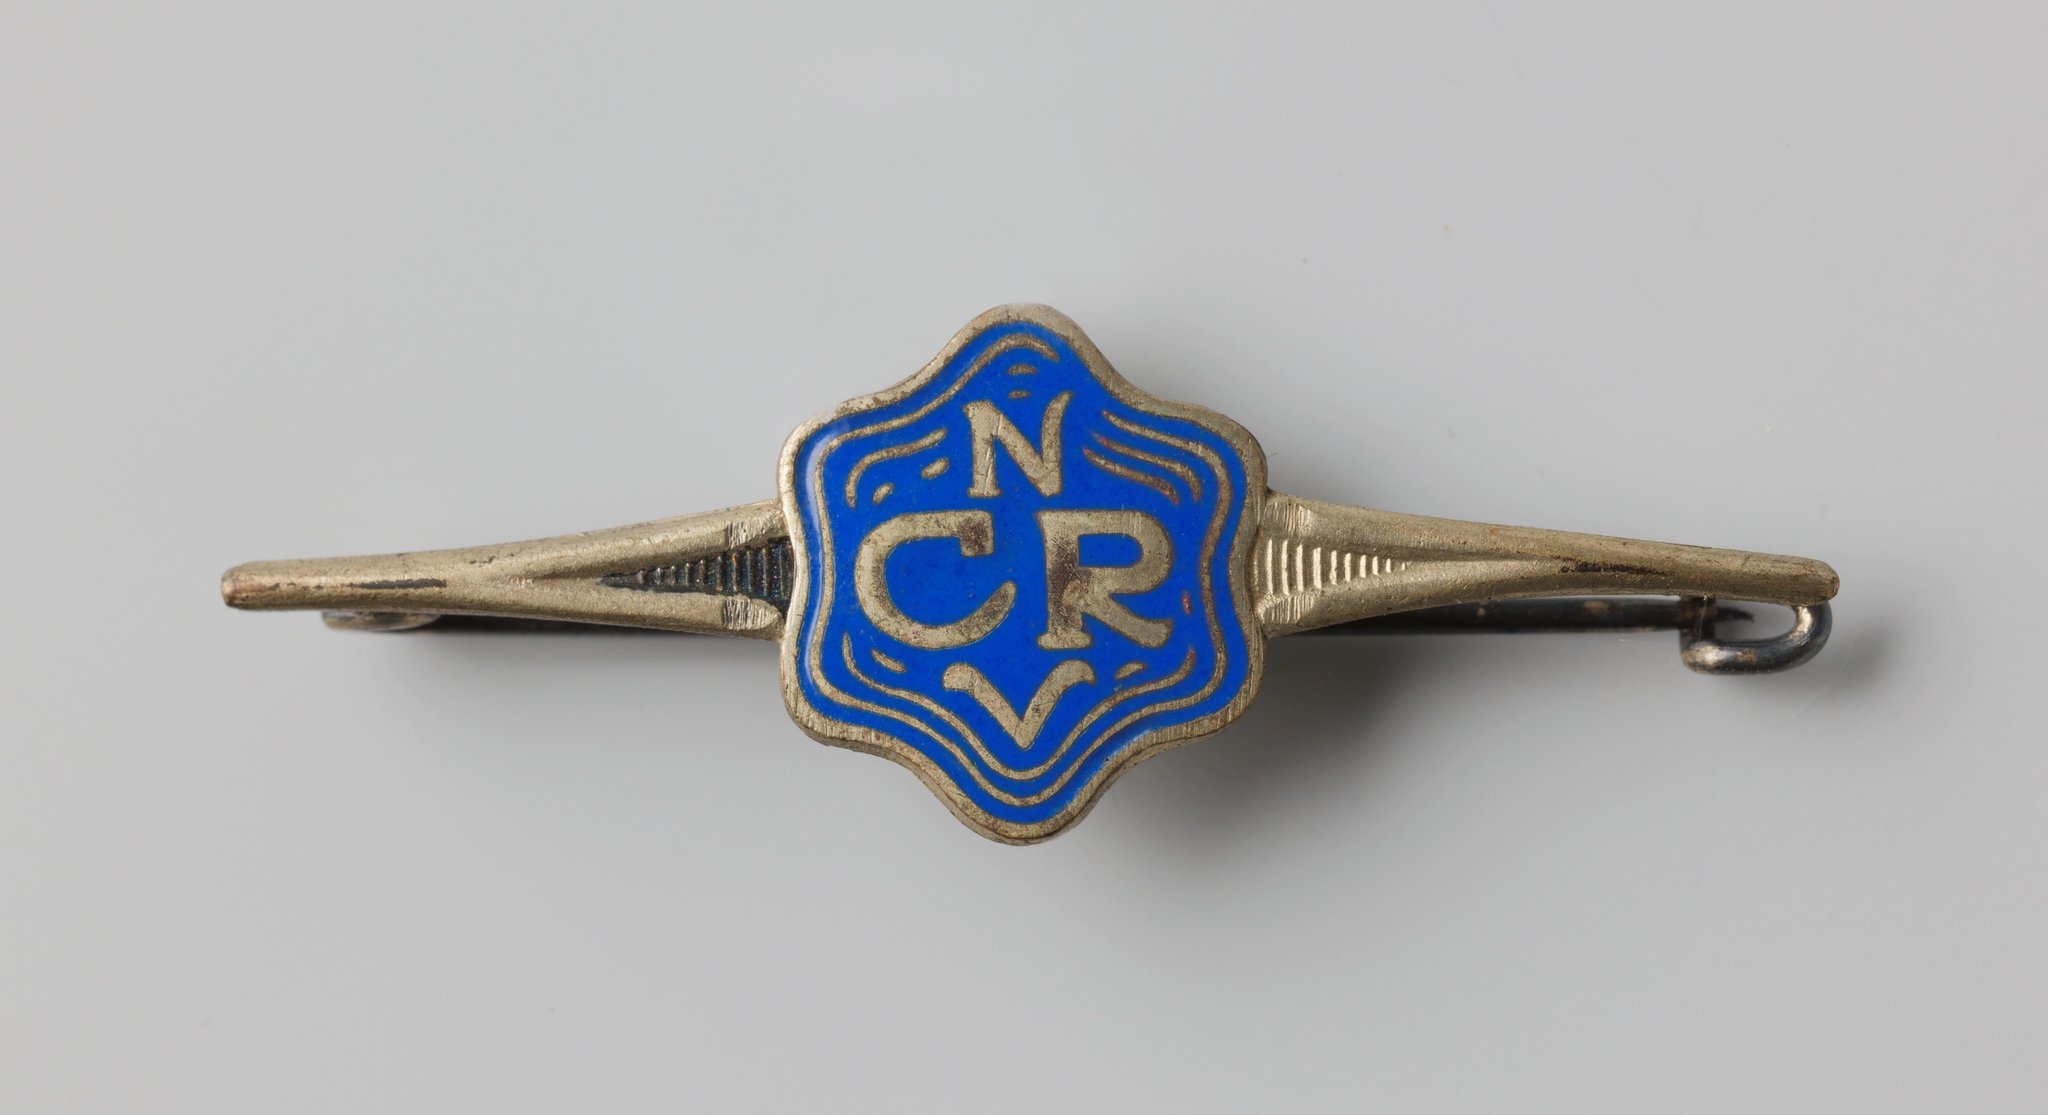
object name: pin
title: Reversspeld van de Nederlandse Christelijke Radio Vereniging (NCRV)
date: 1924-1994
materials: metal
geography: netherlands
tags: netherlands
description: Metalen zeshoek met afgeronde hoeken. De achtergrond is blauw en heeft lijnen die vorm van de speld volgen. Centraal de letters: N / C R / V. De zeshoek vormt het hart van een horizontale speld. Links en rechts loopt de speld uit in een punt. Op de keerzijde is een veiligheidsspeld gemonteerd. Het embleem is verwant met NG-1995-5-1, NG-1995-5-3 en NG-1995-5-7.